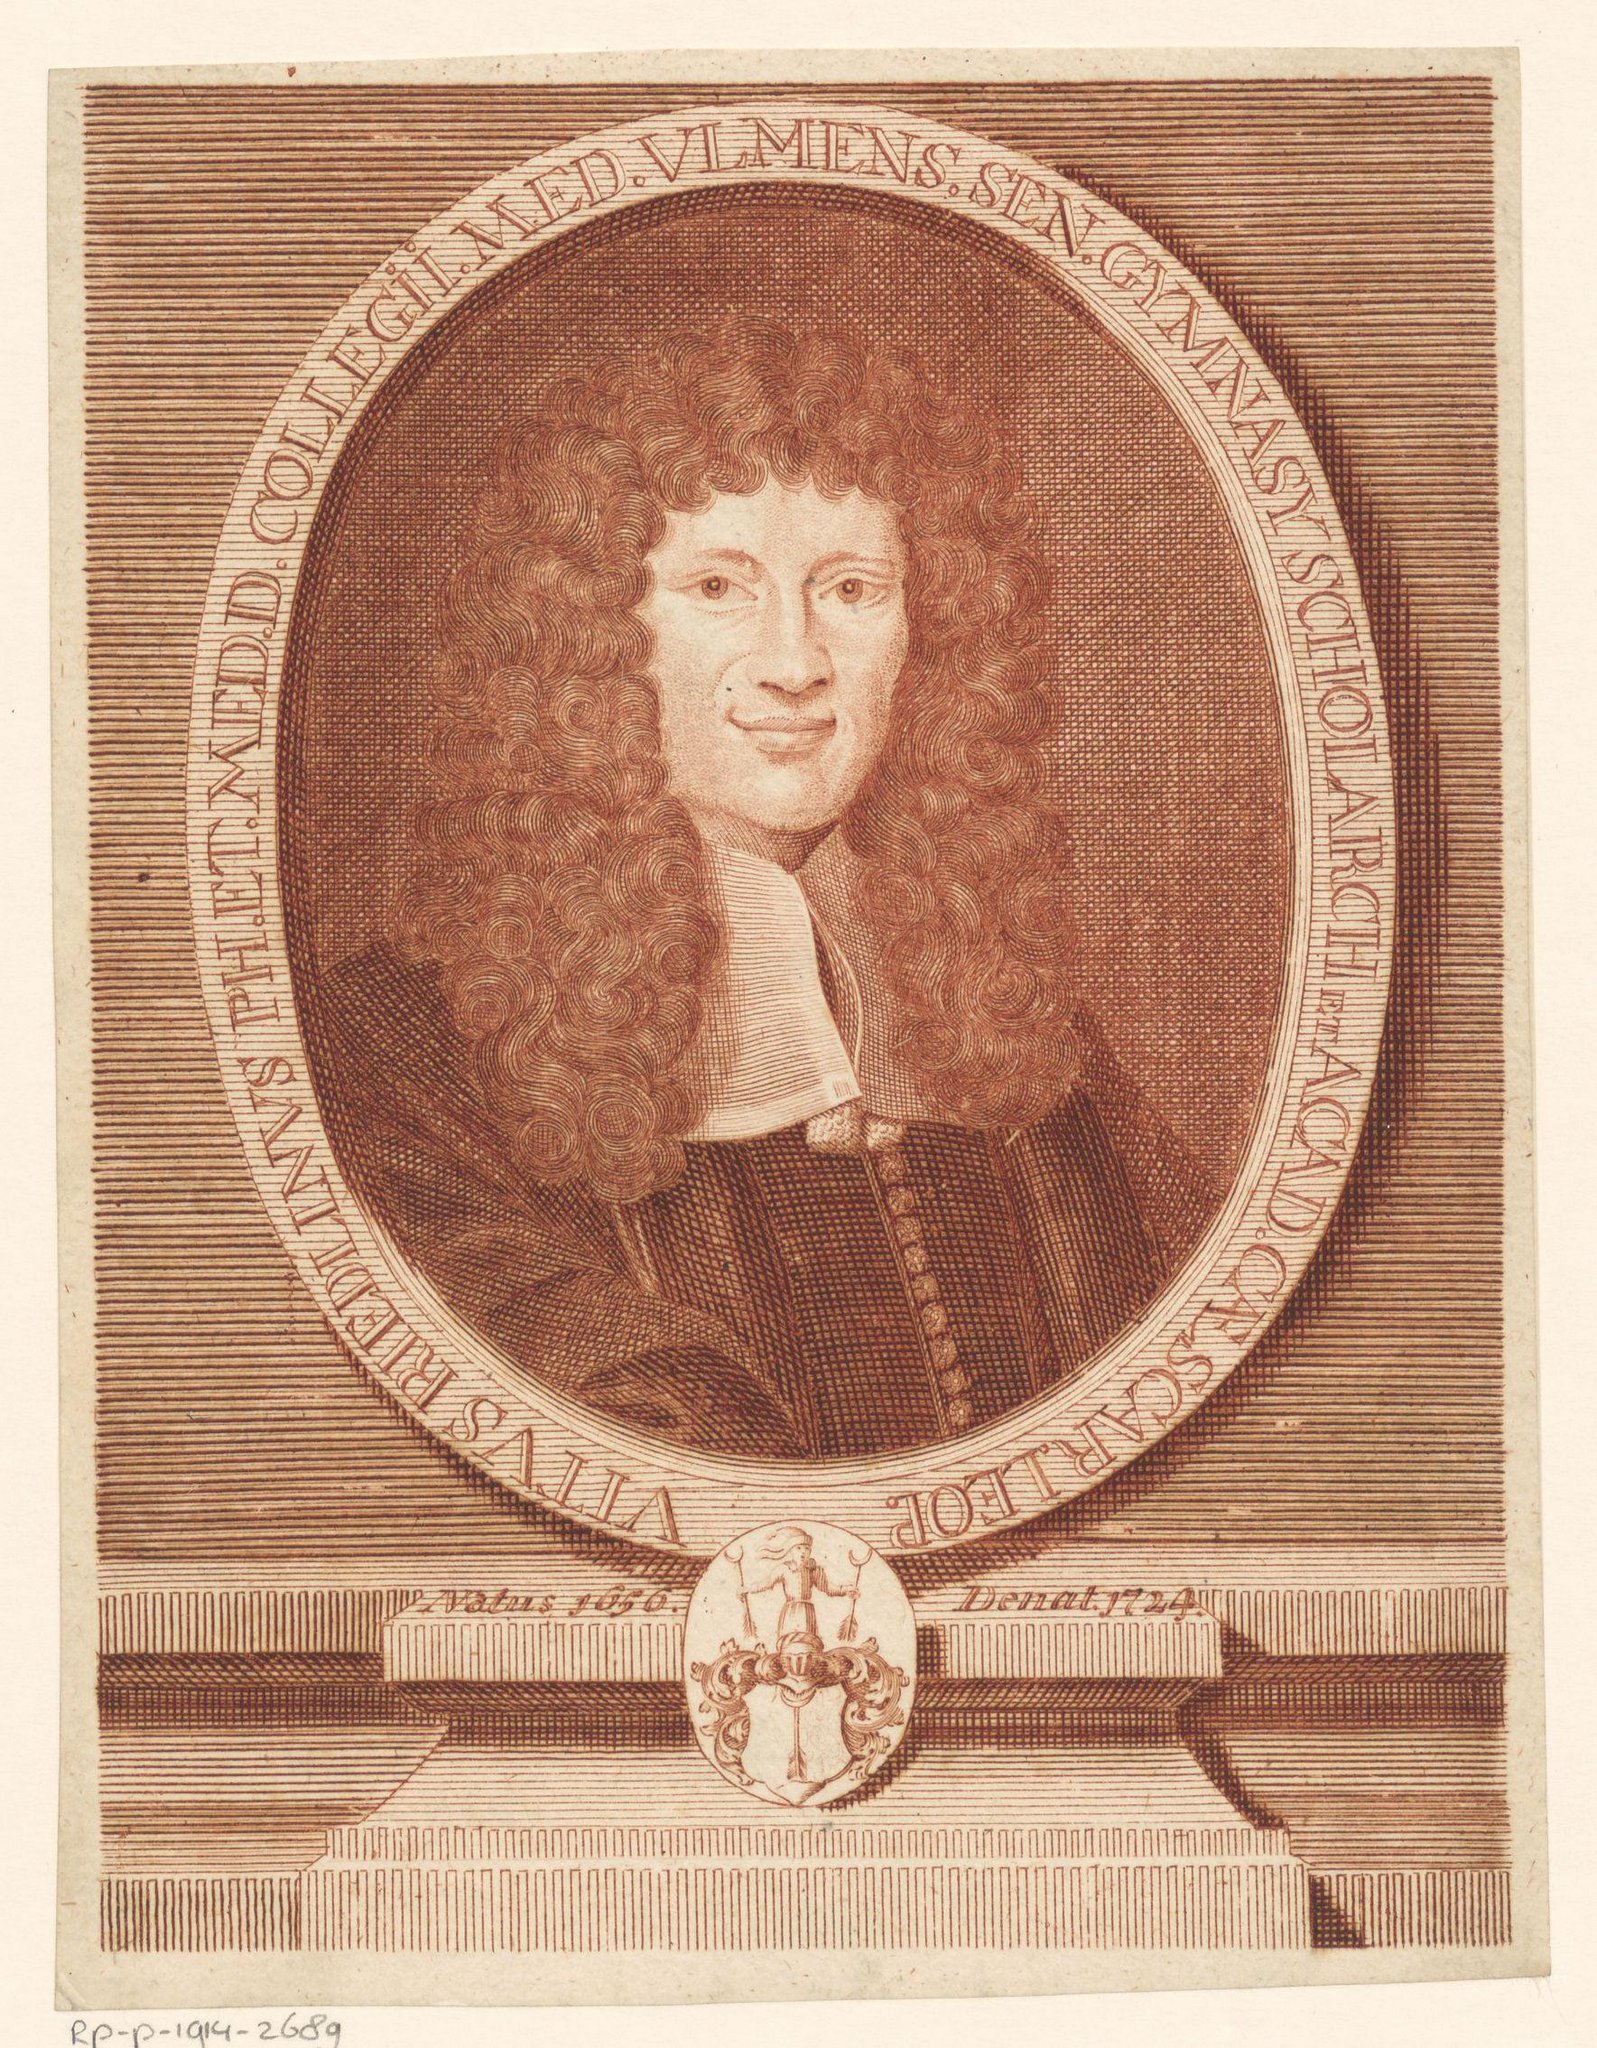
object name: print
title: Portret van Veit Riedlin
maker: johann adam delsenbach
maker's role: print maker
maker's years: 1687-1765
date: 1724-1765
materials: paper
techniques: engraving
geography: nuremberg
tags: veit riedlin, historical persons, armorial bearing, heraldry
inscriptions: collector's mark: Lugt 2228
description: Het RMA heeft een tweede, in zwarte inkt gedrukt, exemplaar in bezit.